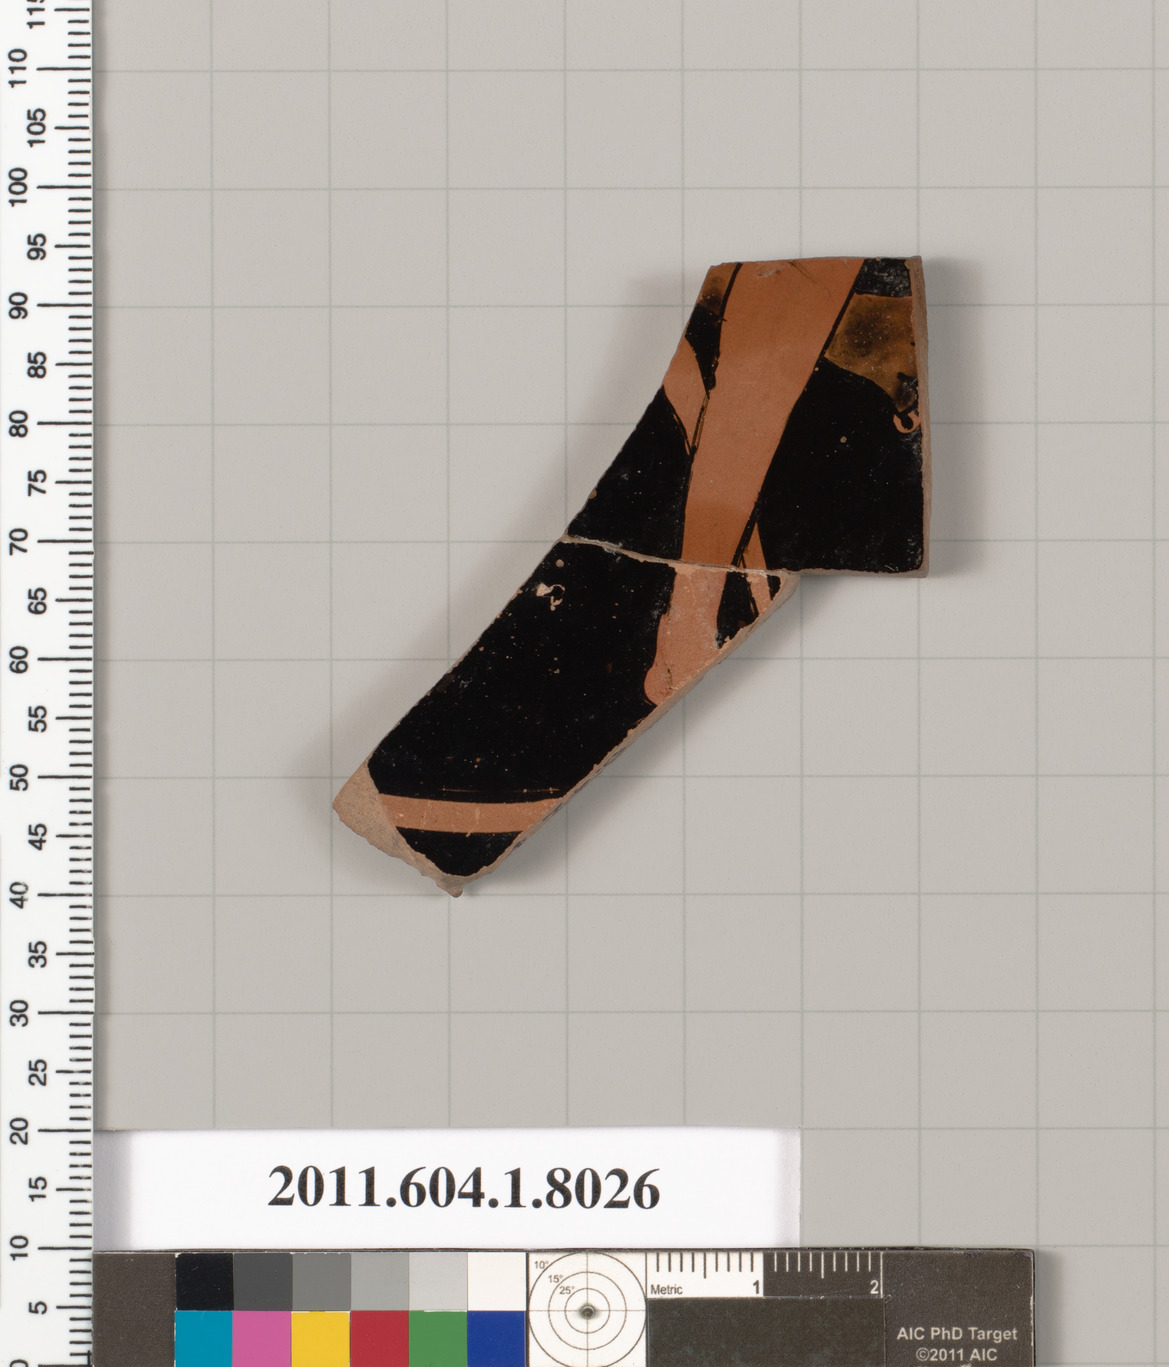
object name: kylix fragment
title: Terracotta fragment of a kylix (drinking cup)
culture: greek, attic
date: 510-500 BCE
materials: terracotta